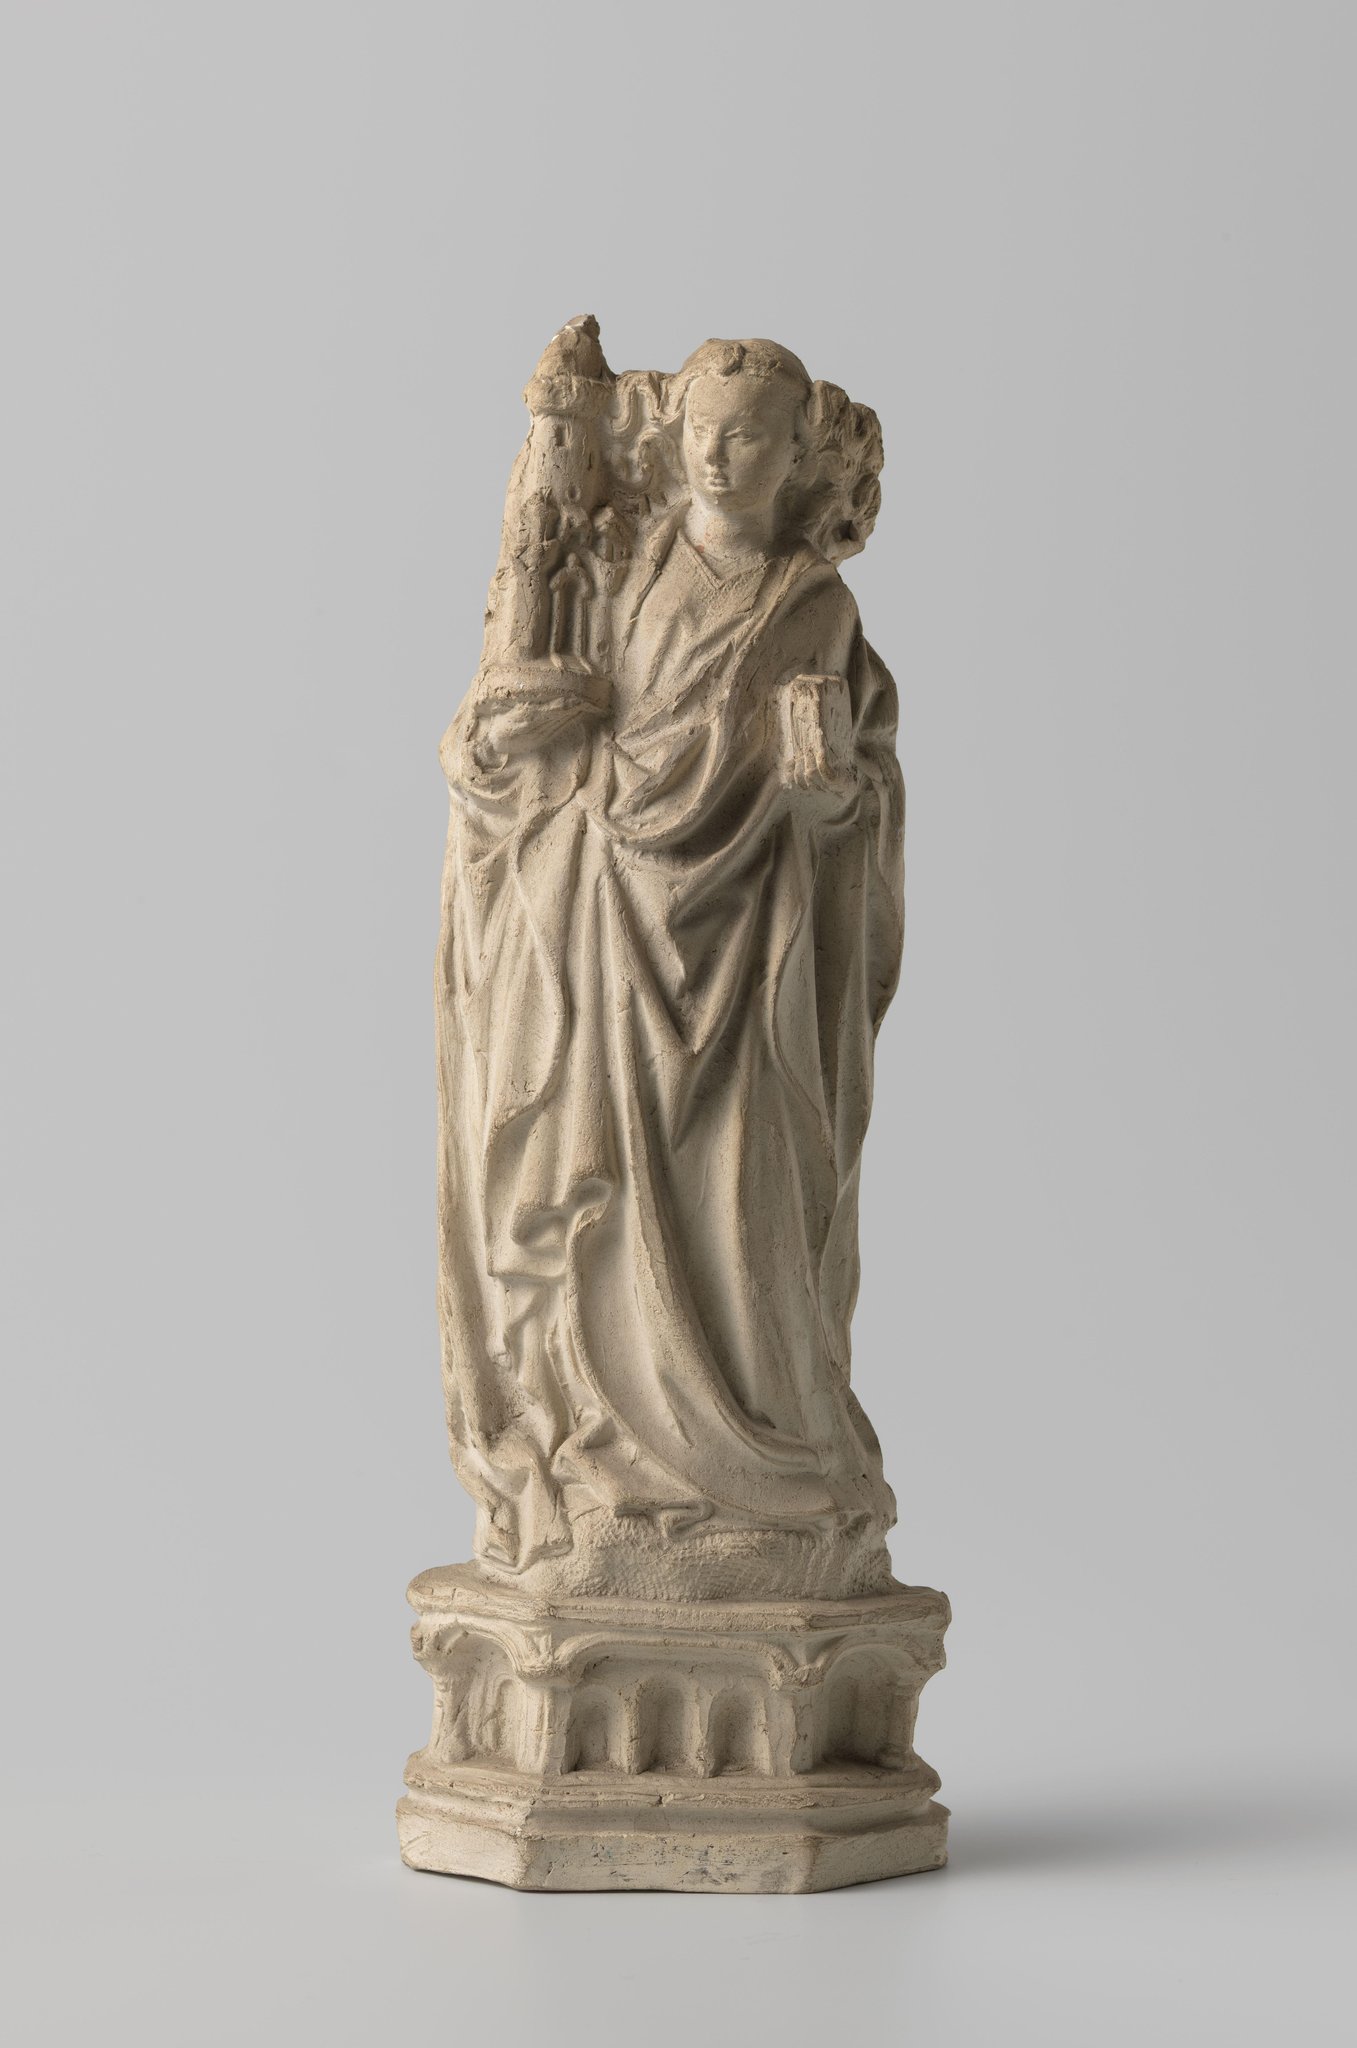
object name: figure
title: Beeld van St. Barbara op voetstuk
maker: Anonymous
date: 1500-1550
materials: gypsum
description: Beeld van St. Barbara op voetstuk. Staand figuur. Afgietsel in gips. De vormen bevinden zich in de gemeenteverzameling in Utrecht.